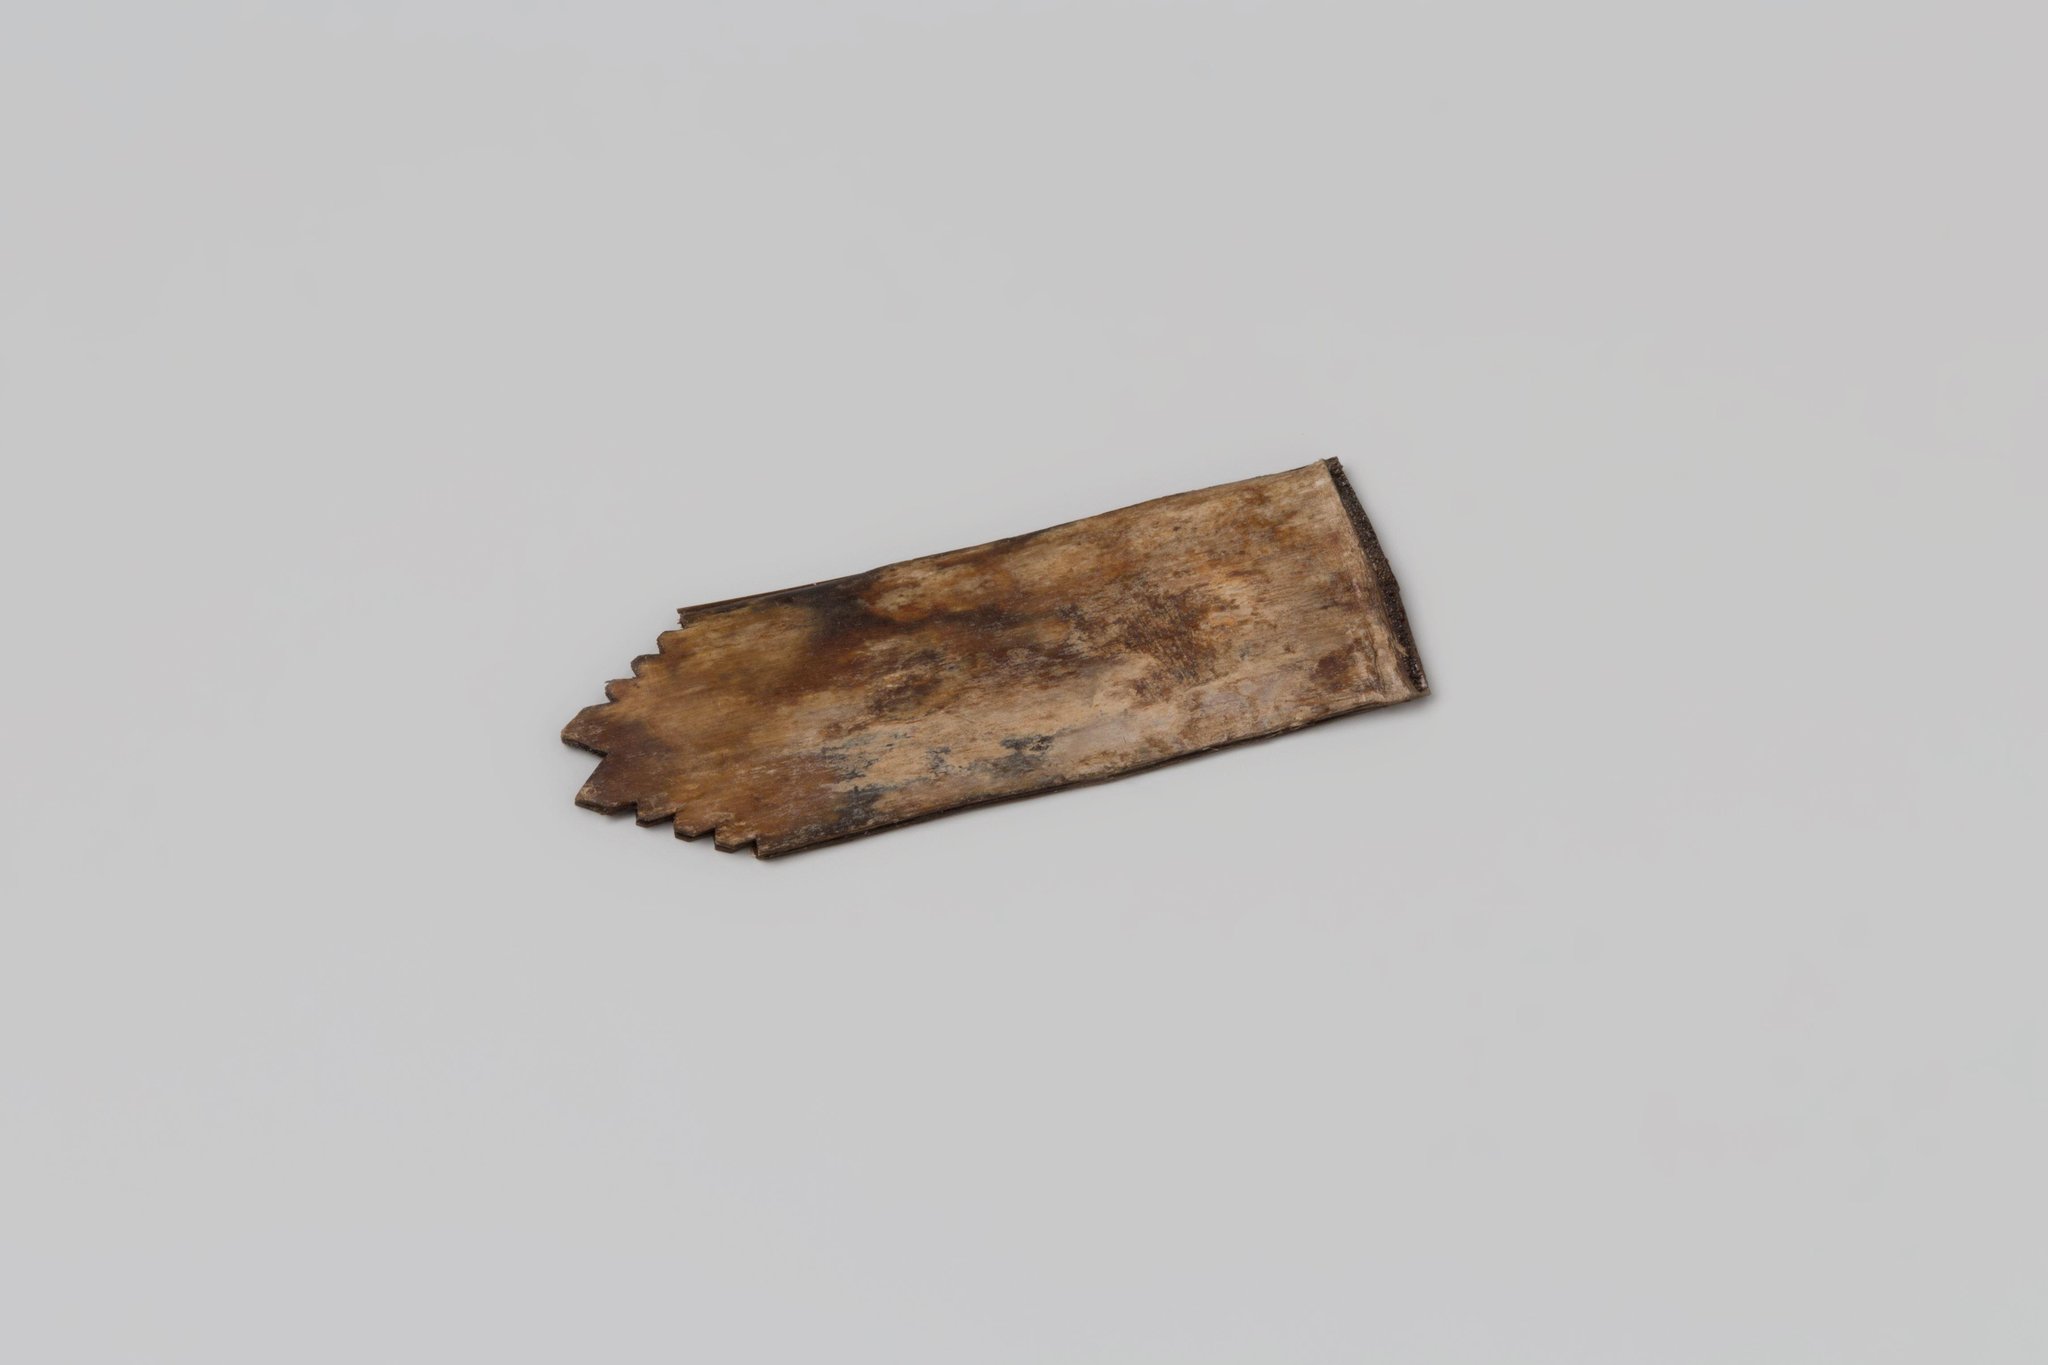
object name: reception piece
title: Proefstuk met balein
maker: Anonymous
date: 1400-1950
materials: baleen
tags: zeeuwsche uytkyck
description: Proefstuk met balein; één van de korte kanten is gekarteld.